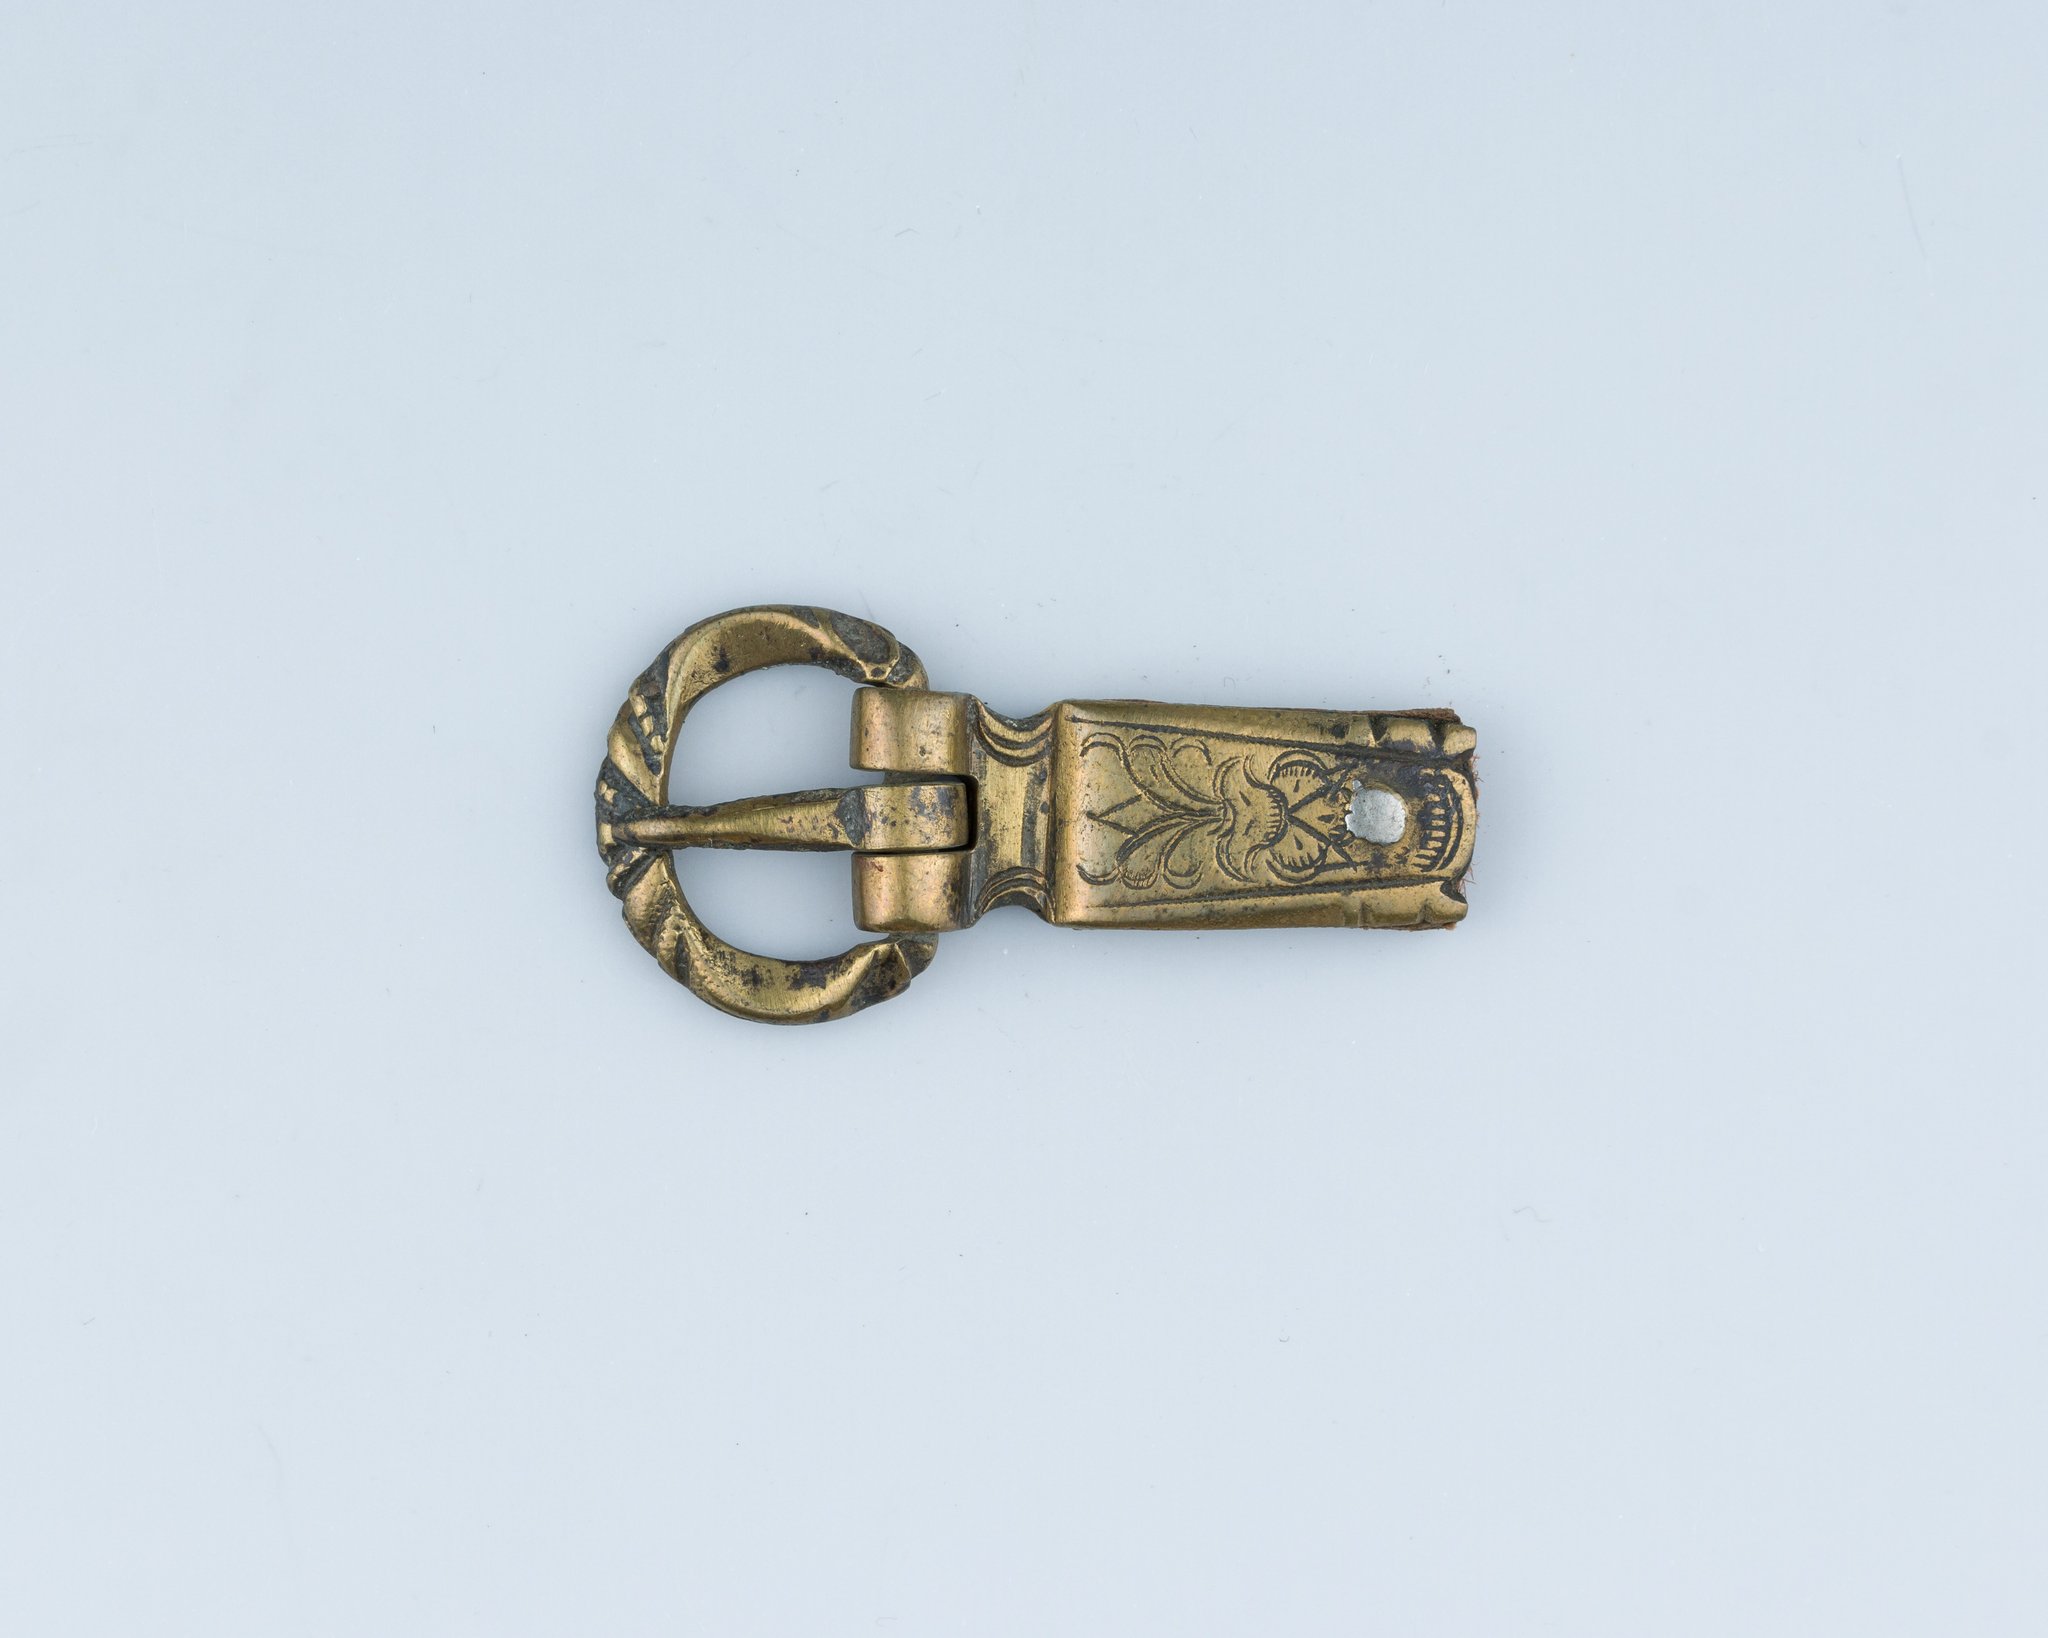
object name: buckle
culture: french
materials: brass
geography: france